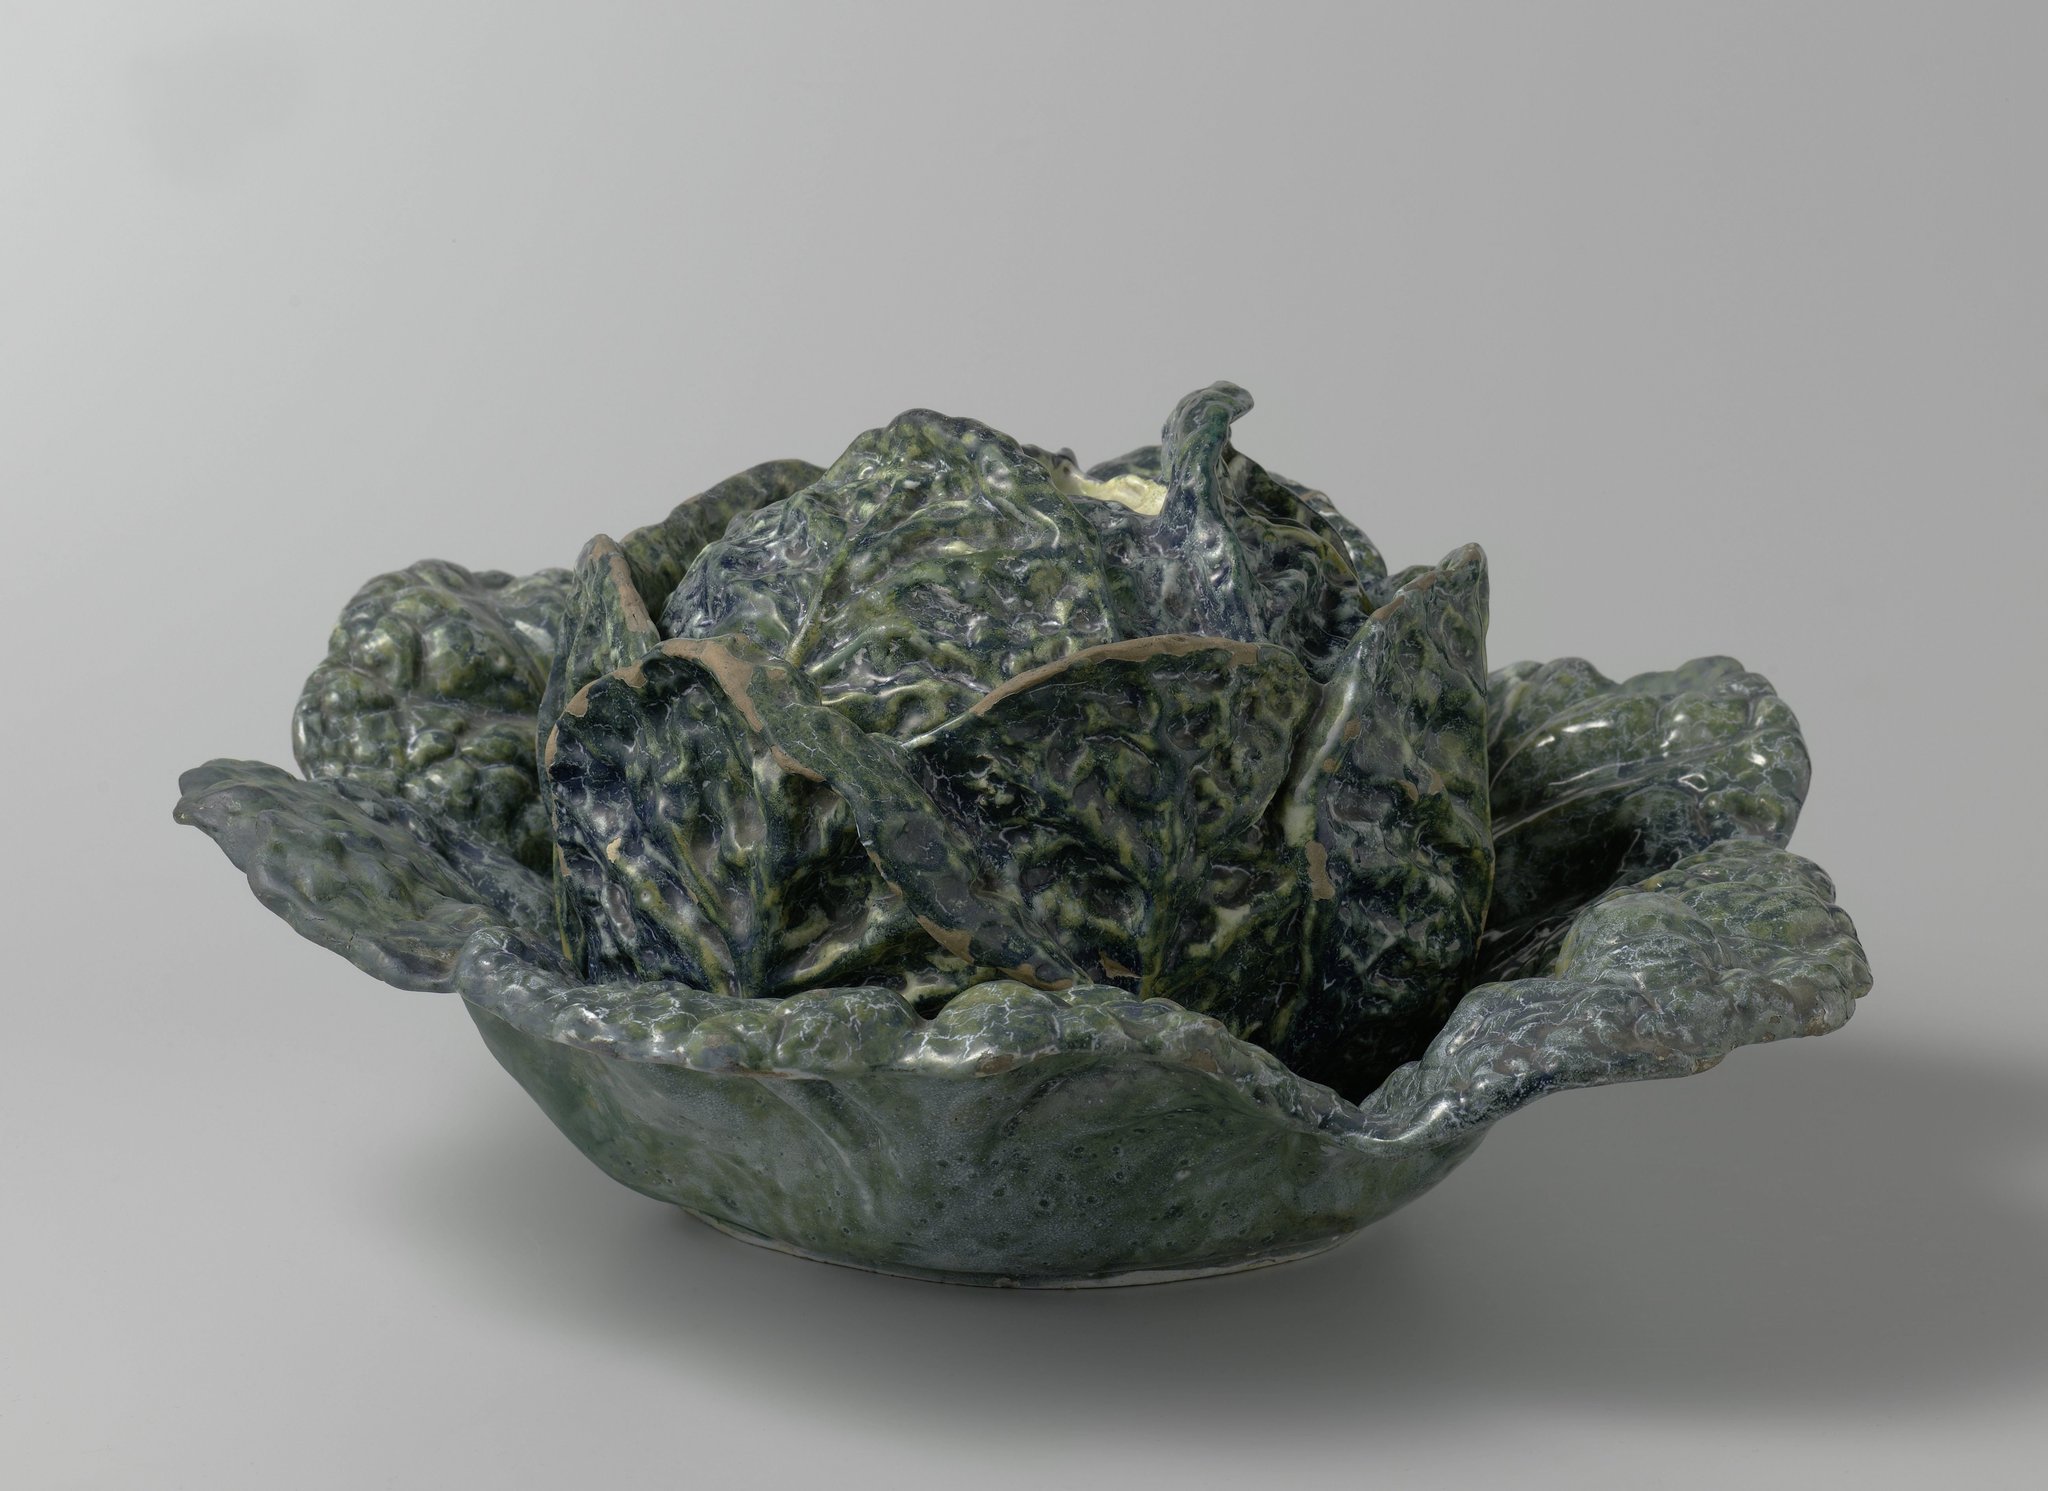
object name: soup tureen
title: Soepterrine in de vorm van een groene kool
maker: Anonymous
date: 1750-1780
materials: earthenware, glaze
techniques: painted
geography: brussels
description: Soepterrine in de vorm van een groene kool, van groen beschilderde faience.